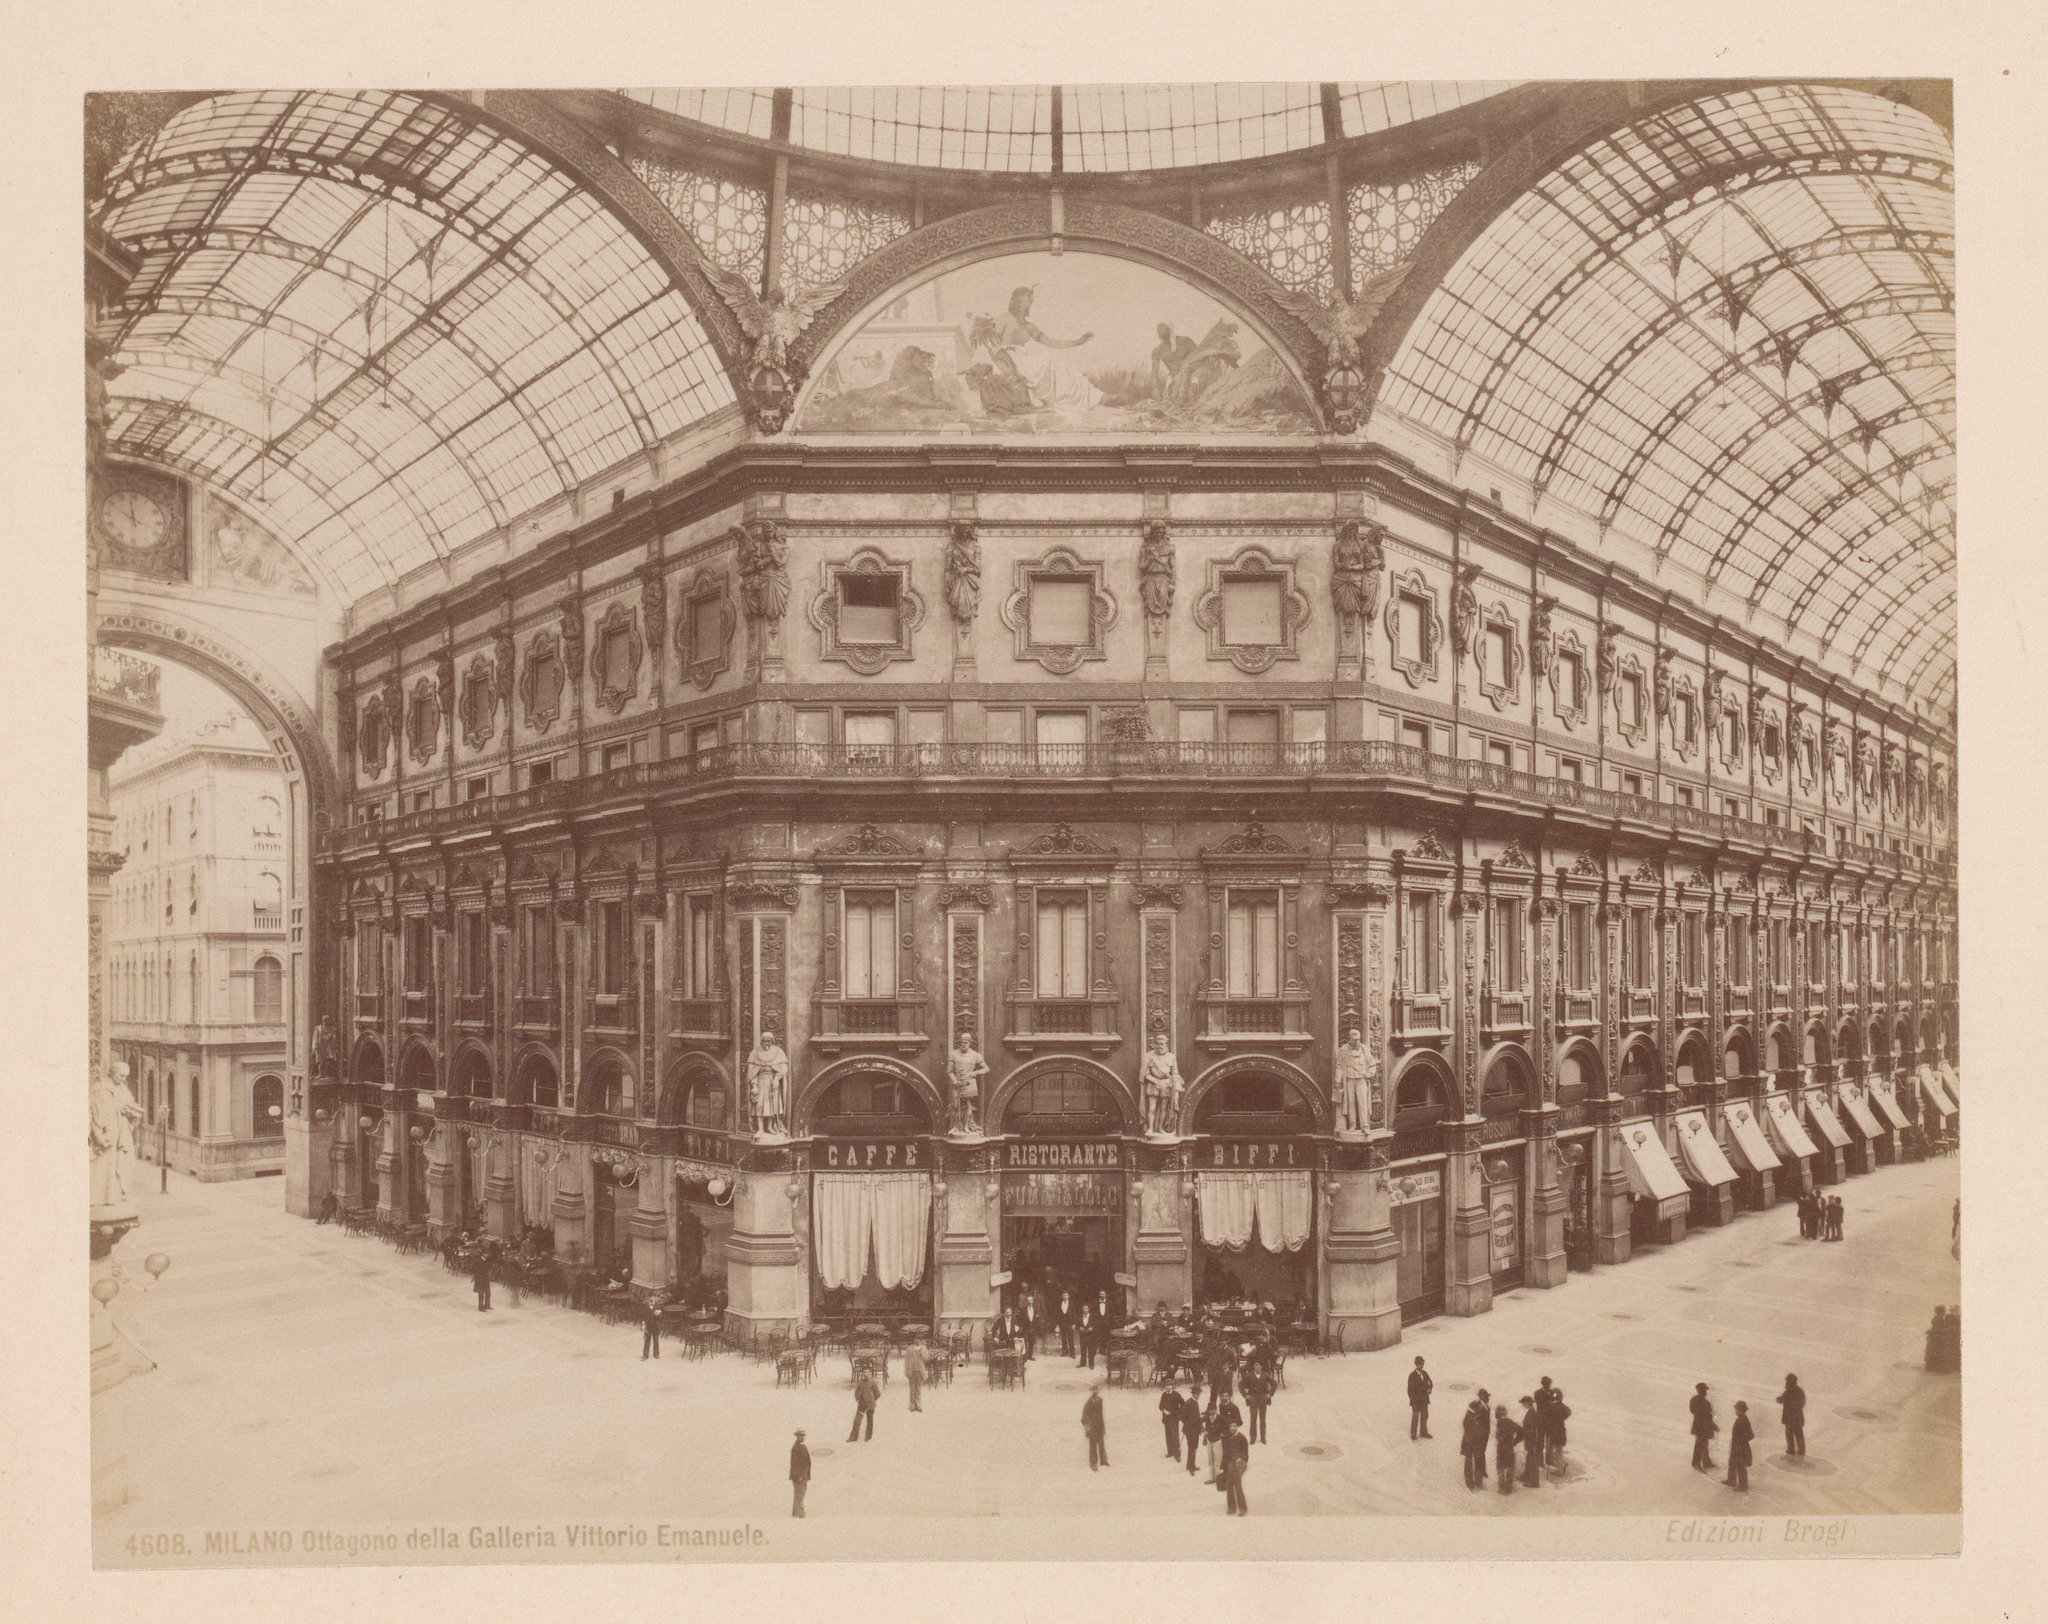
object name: photograph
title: Koepel van Galleria Vittorio Emanuele, Milaan, Italië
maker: giacomo brogi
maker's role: fotograaf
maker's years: 1822-1881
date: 1860-1890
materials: cardboard, paper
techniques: albumen print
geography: florence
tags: galleria vittorio emanuele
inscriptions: caption: ‘(EDIZIONI BROGI)’, caption: ‘4608. MILANO. Ottagono della Galleria Vittorio Emanuele’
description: Koepel van Galleria Vittorio Emanuele, Milaan, Italië.